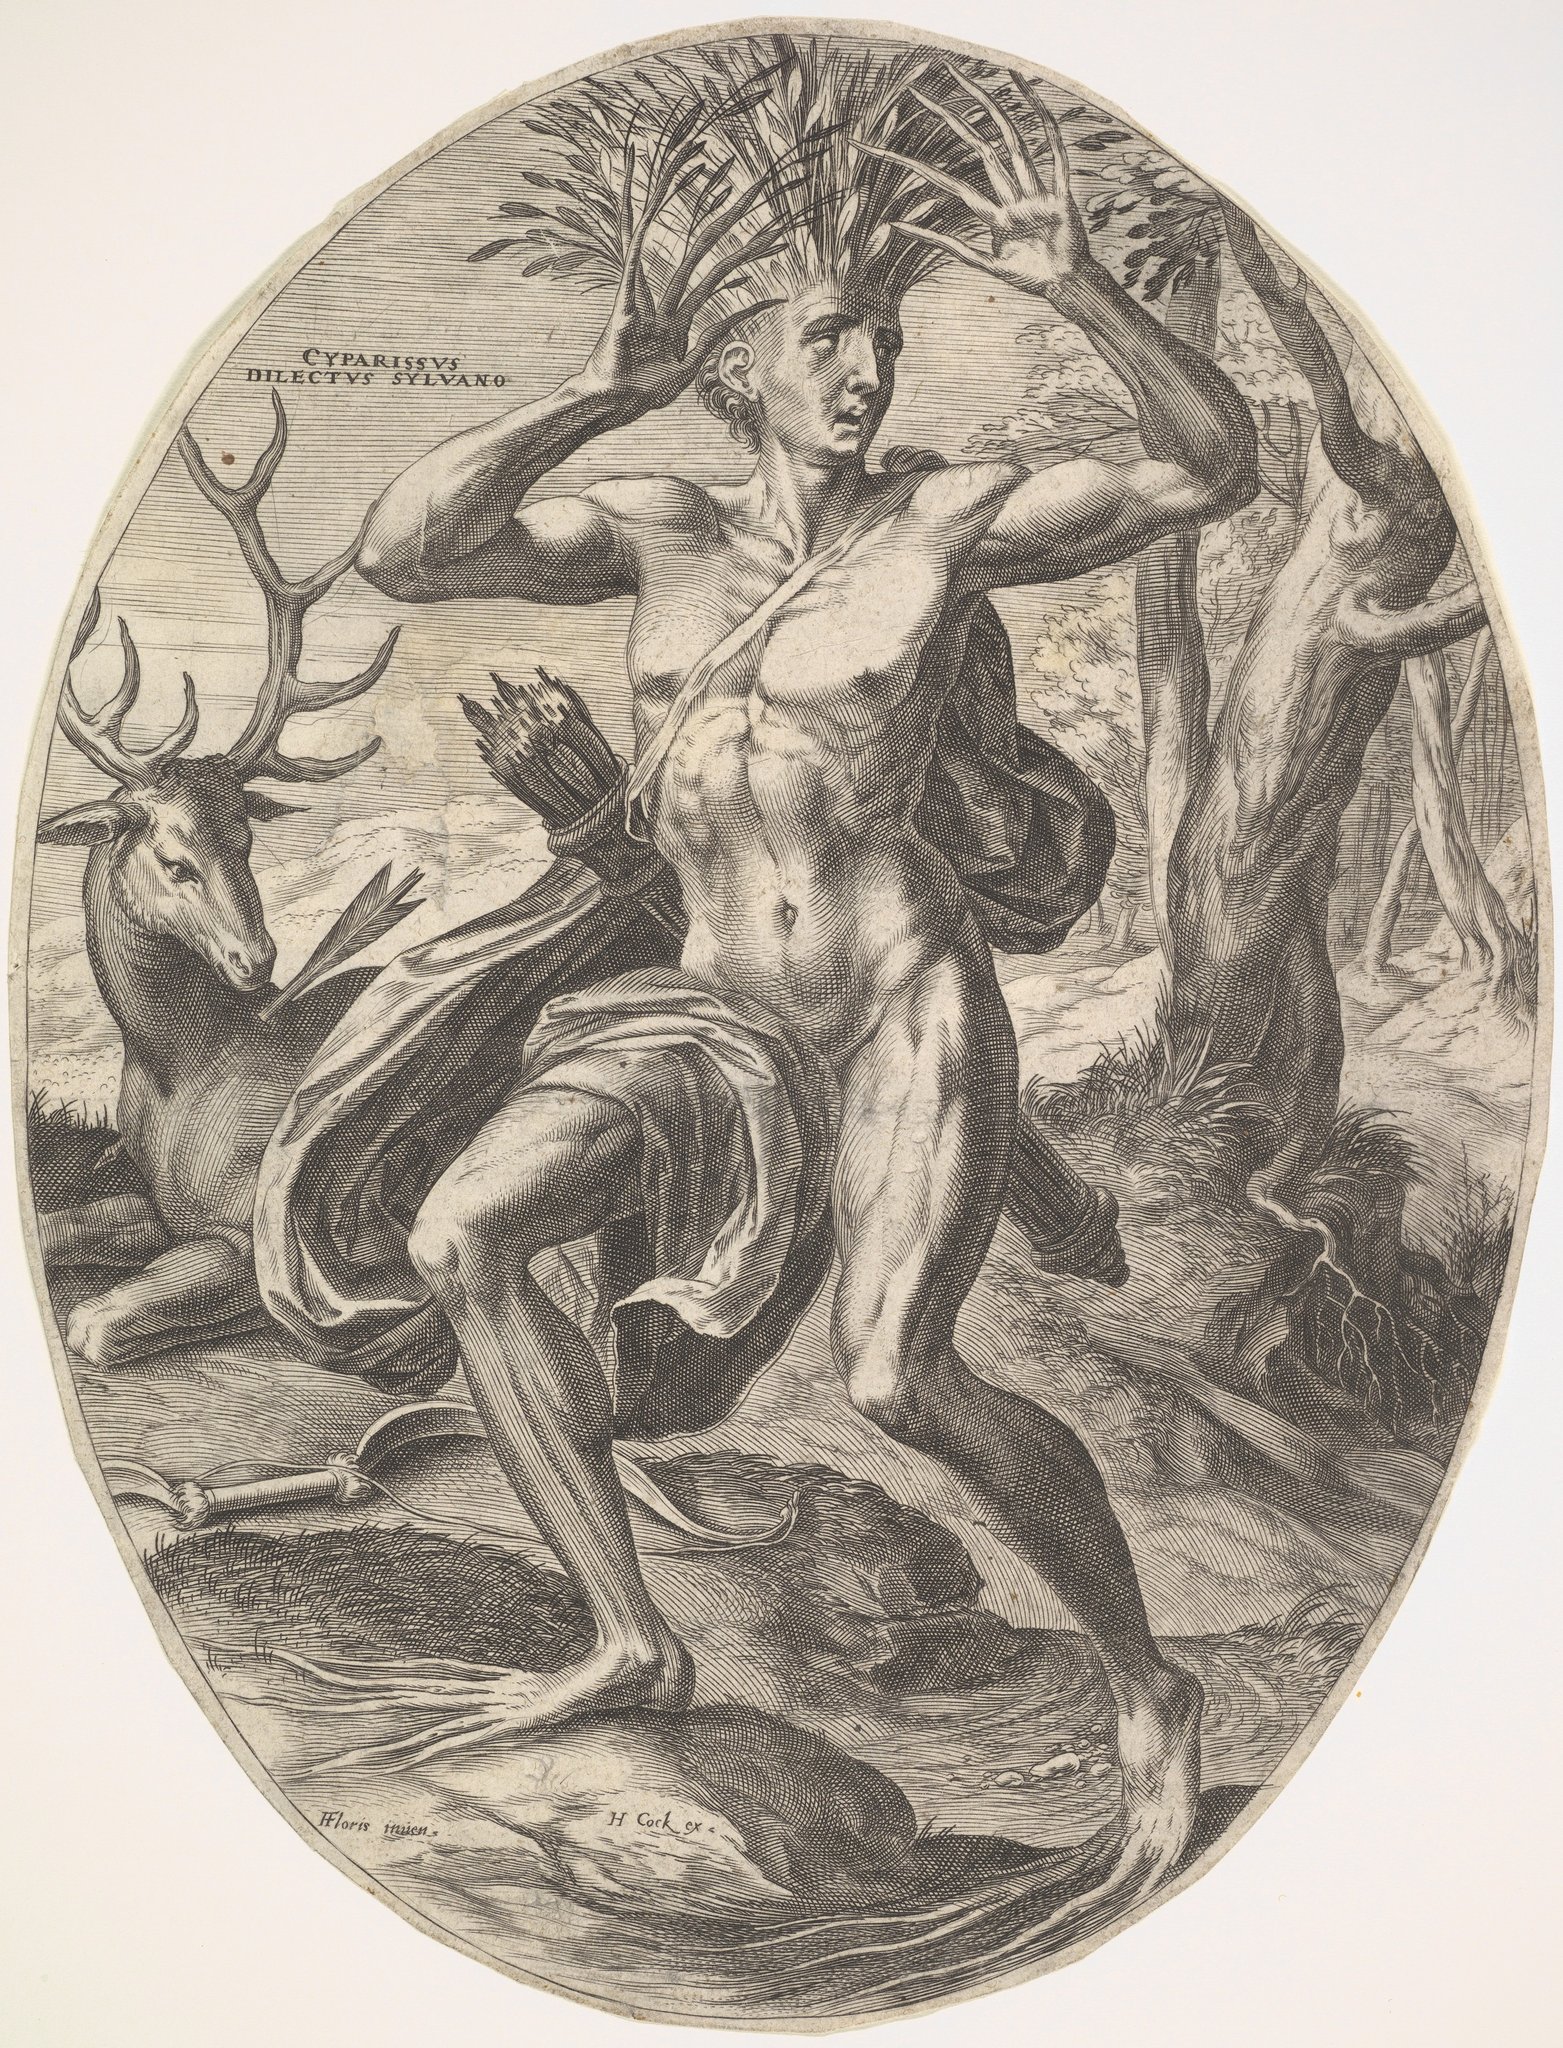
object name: print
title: Cyparissus, from "The Rural Gods"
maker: cornelis cort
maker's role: artist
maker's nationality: netherlandish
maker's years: 1533-1578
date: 1565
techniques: engraving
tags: men,deer,trees